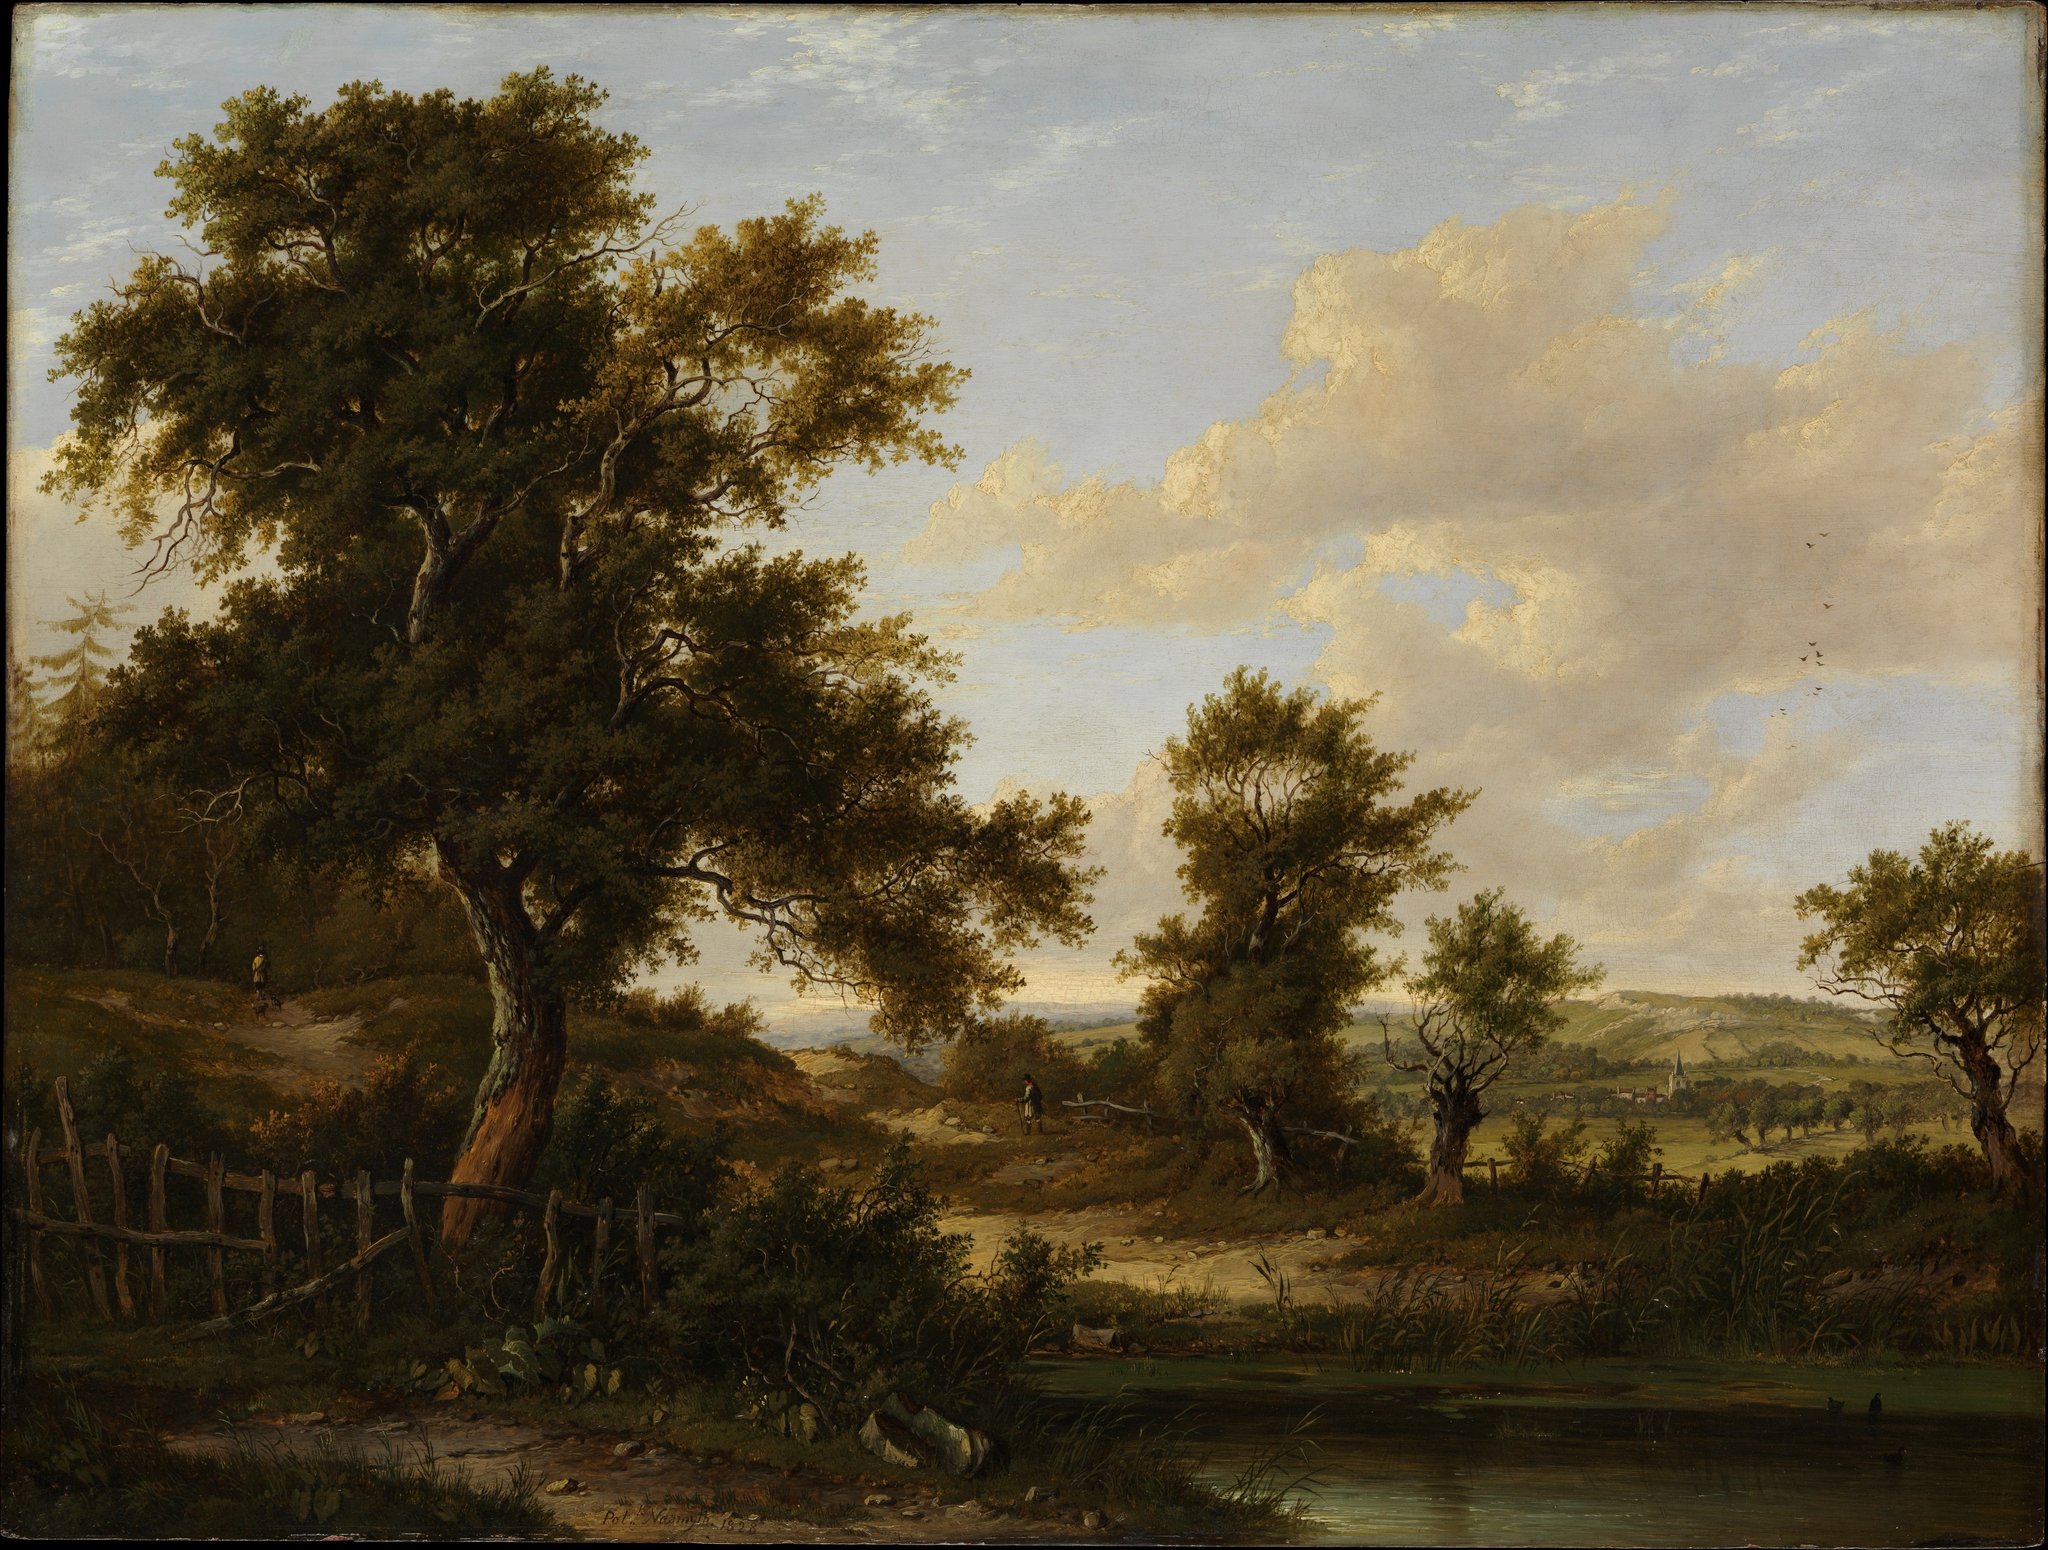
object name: painting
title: Near Penshurst, Kent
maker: patrick nasmyth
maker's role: artist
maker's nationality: british, scottish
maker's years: 1787-1831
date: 1828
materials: oil, wood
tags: landscapes